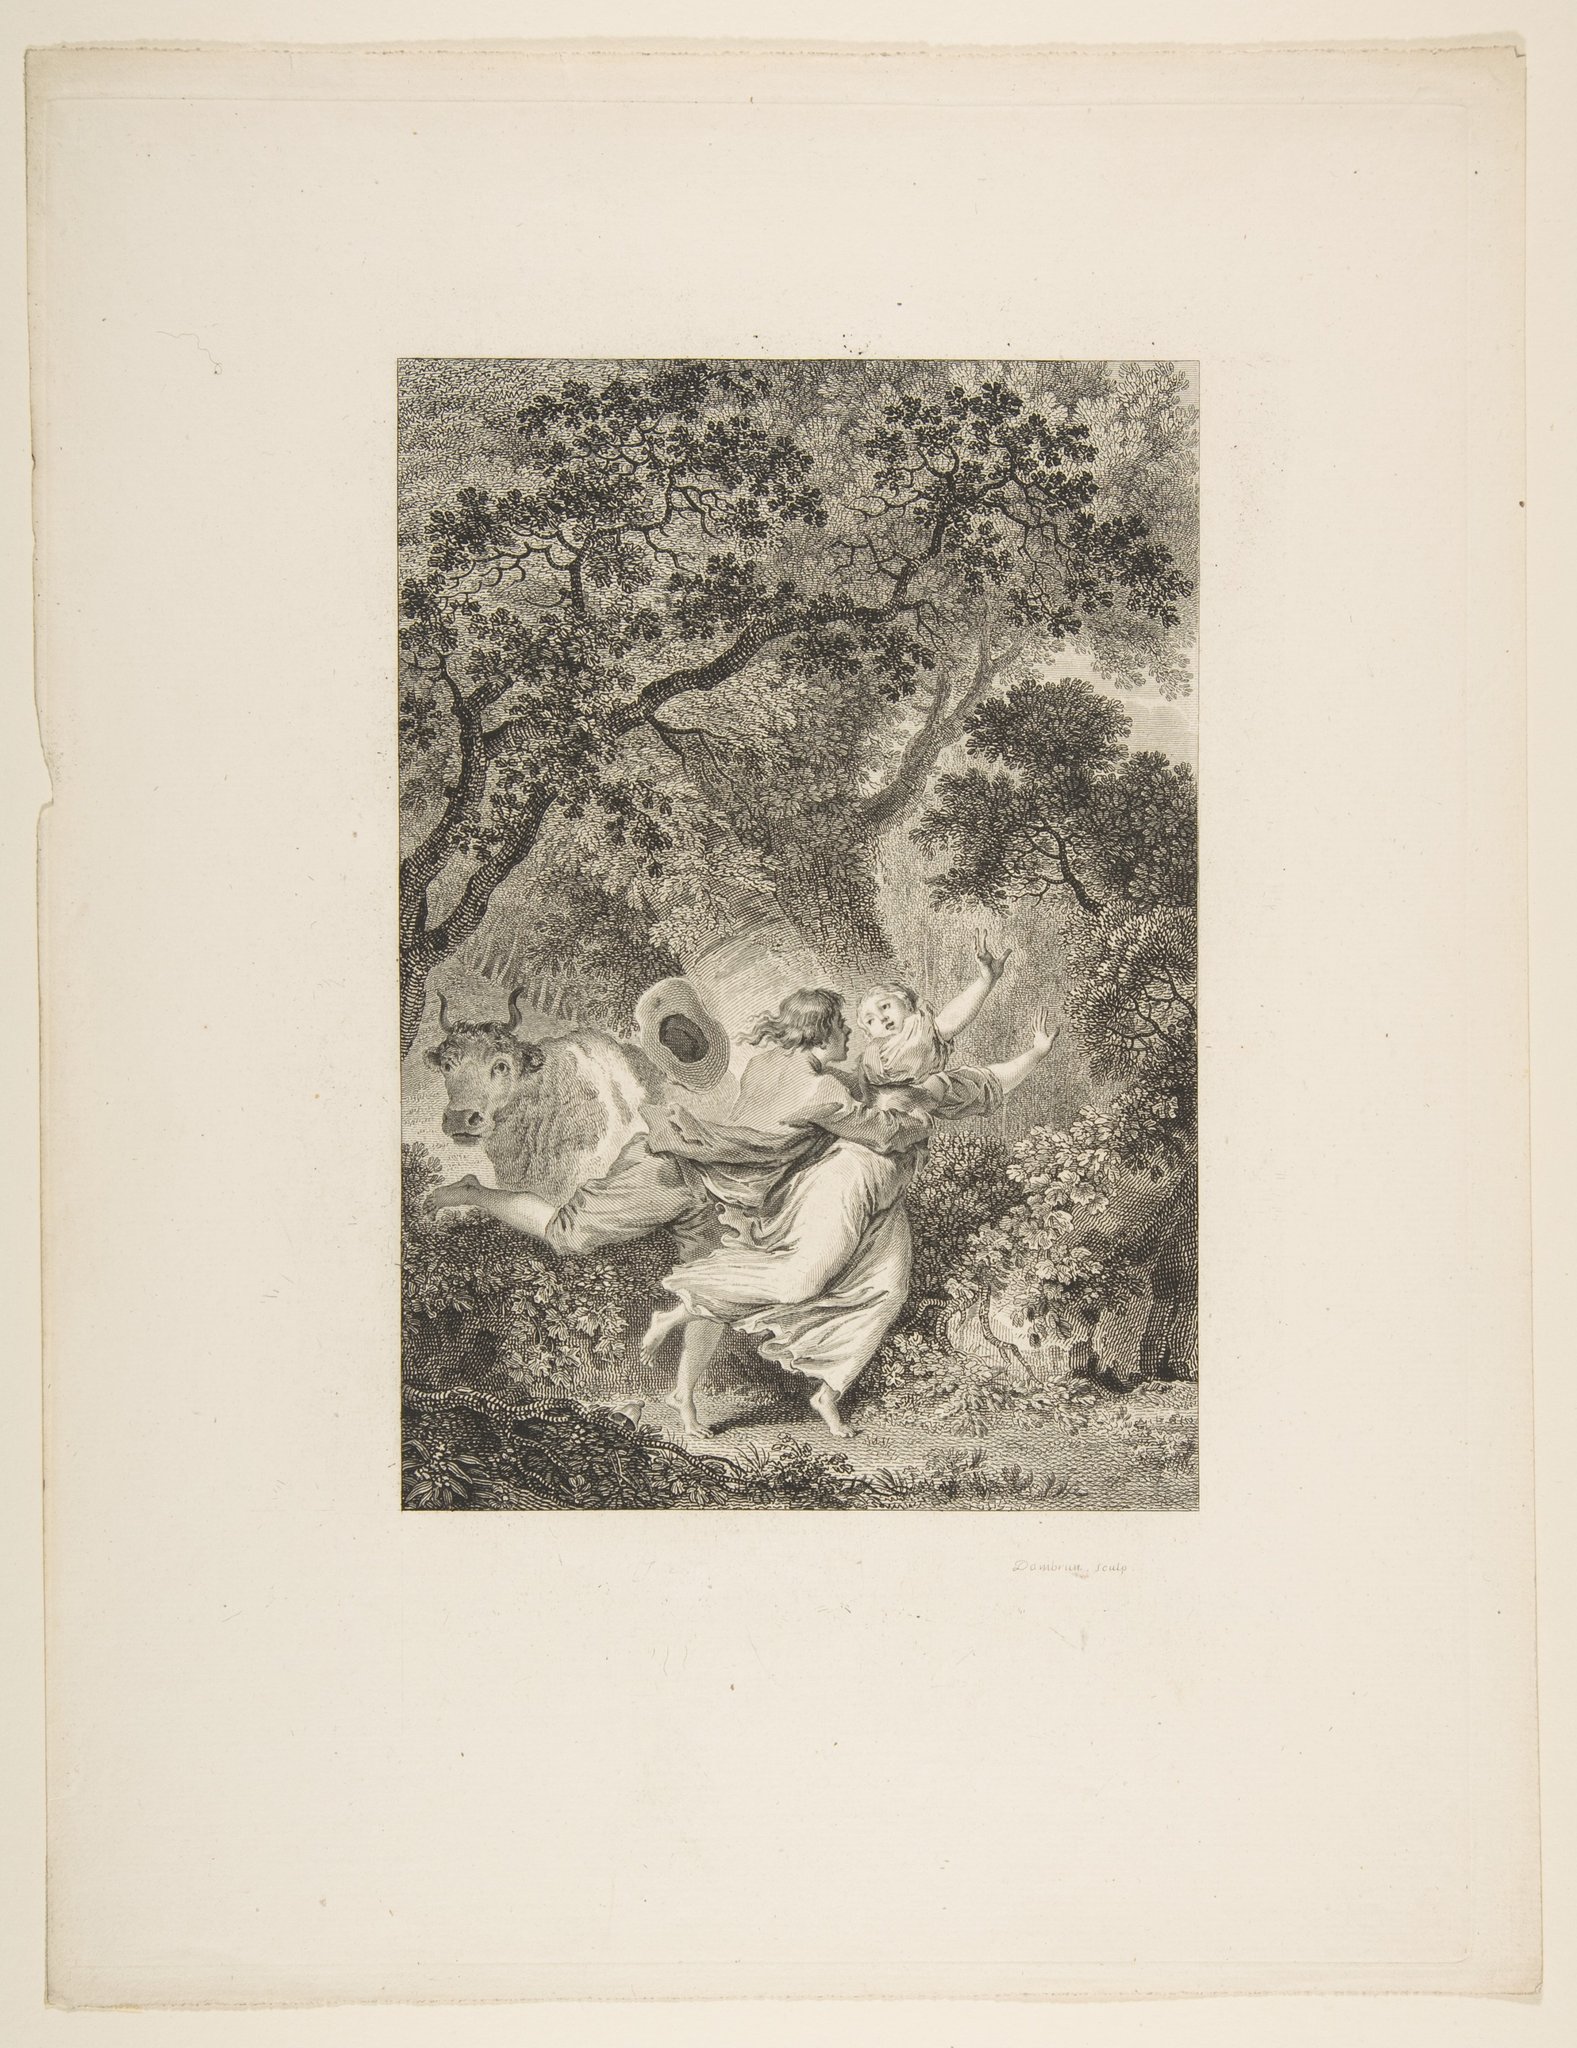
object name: print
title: La Clochette, from "Contes et nouvelles en vers par Jean de La Fontaine"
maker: jean dambrun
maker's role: artist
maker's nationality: french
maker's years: 1741-1808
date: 1795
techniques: etching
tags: men,women,cows